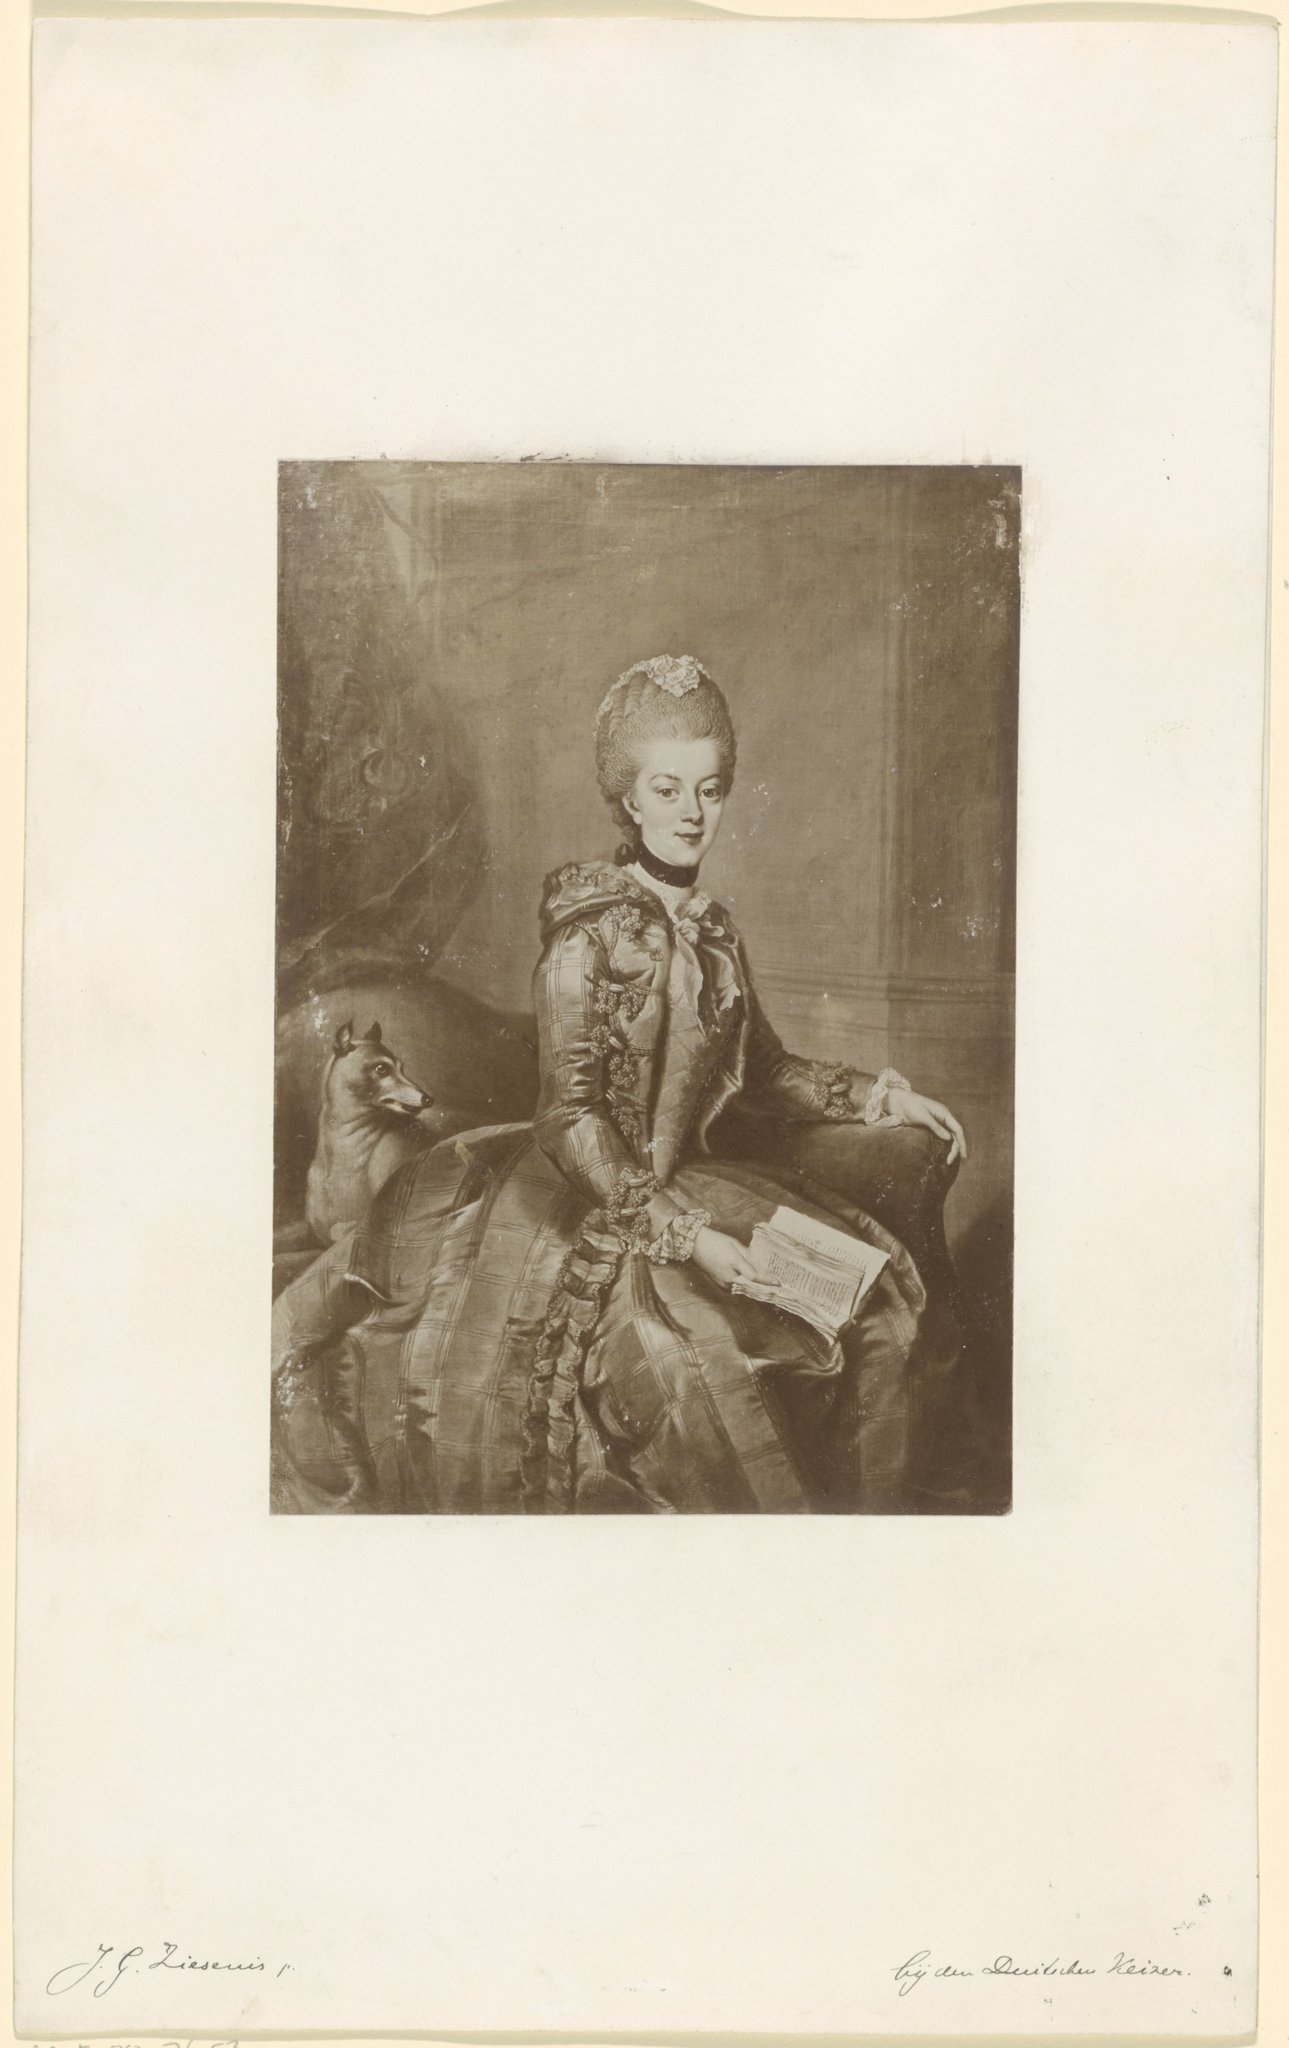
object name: photograph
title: Portret van Wilhelmina van Pruisen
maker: Anonymous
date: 1850-1930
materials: photographic support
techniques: collodion silver print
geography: netherlands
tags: berlin, painter, draughtsman, wilhelmina of prussia (princess of orange)